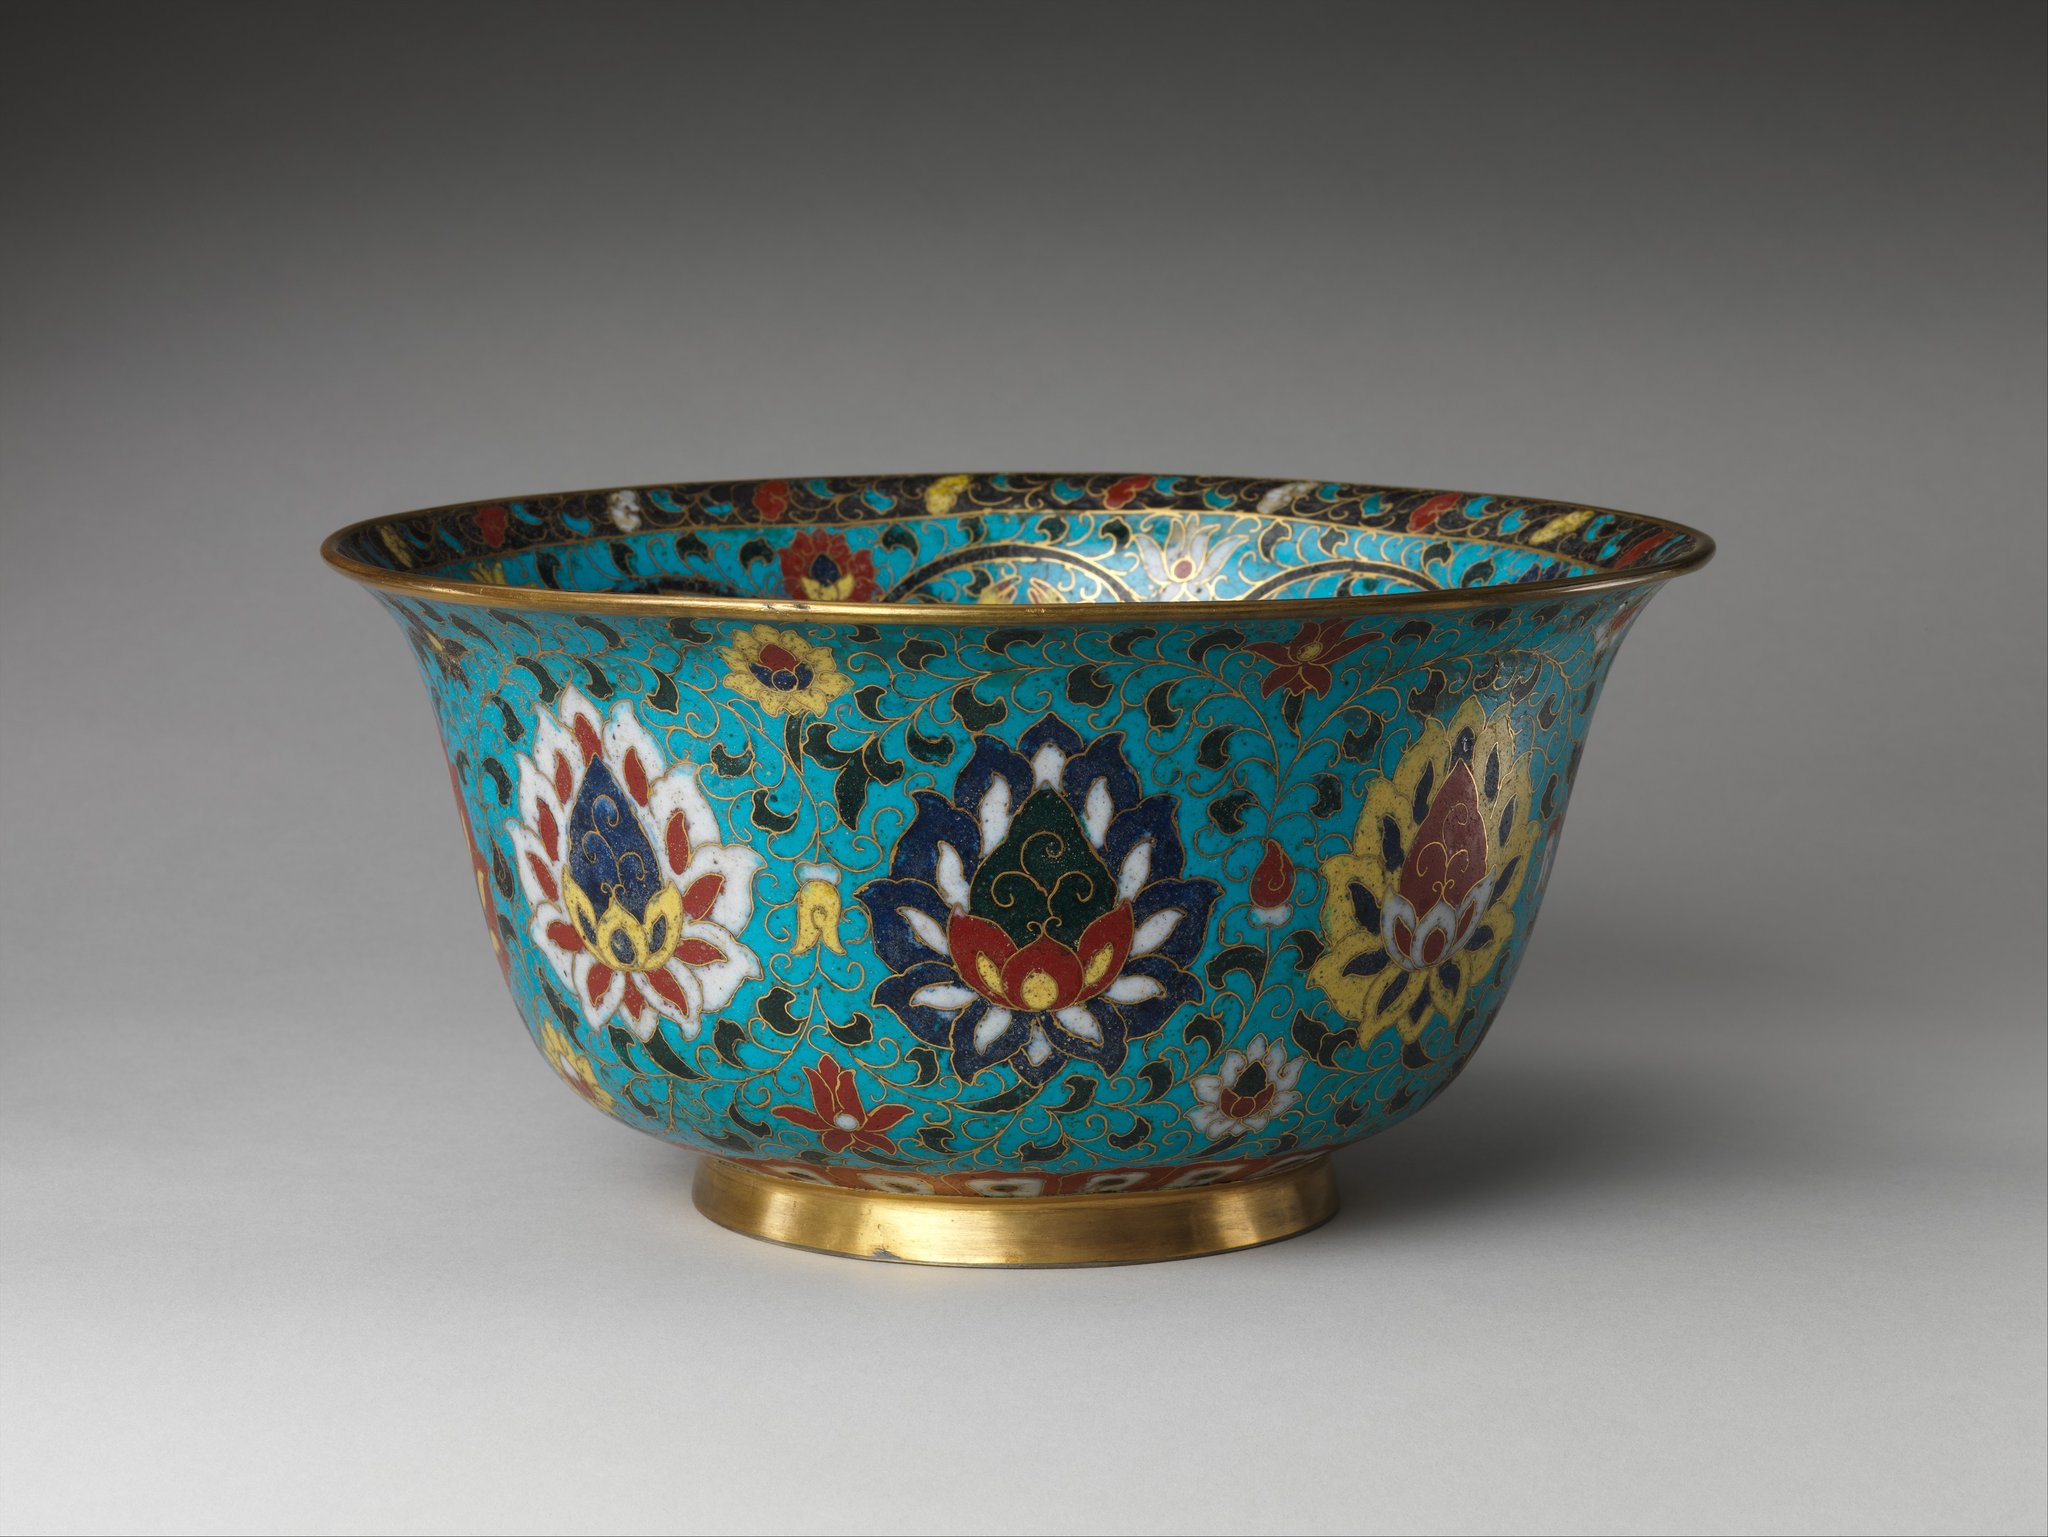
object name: bowl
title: Bowl with the Eight Buddhist Treasures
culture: chinese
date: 1467-1533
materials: enamel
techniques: enamel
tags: fish,flowers